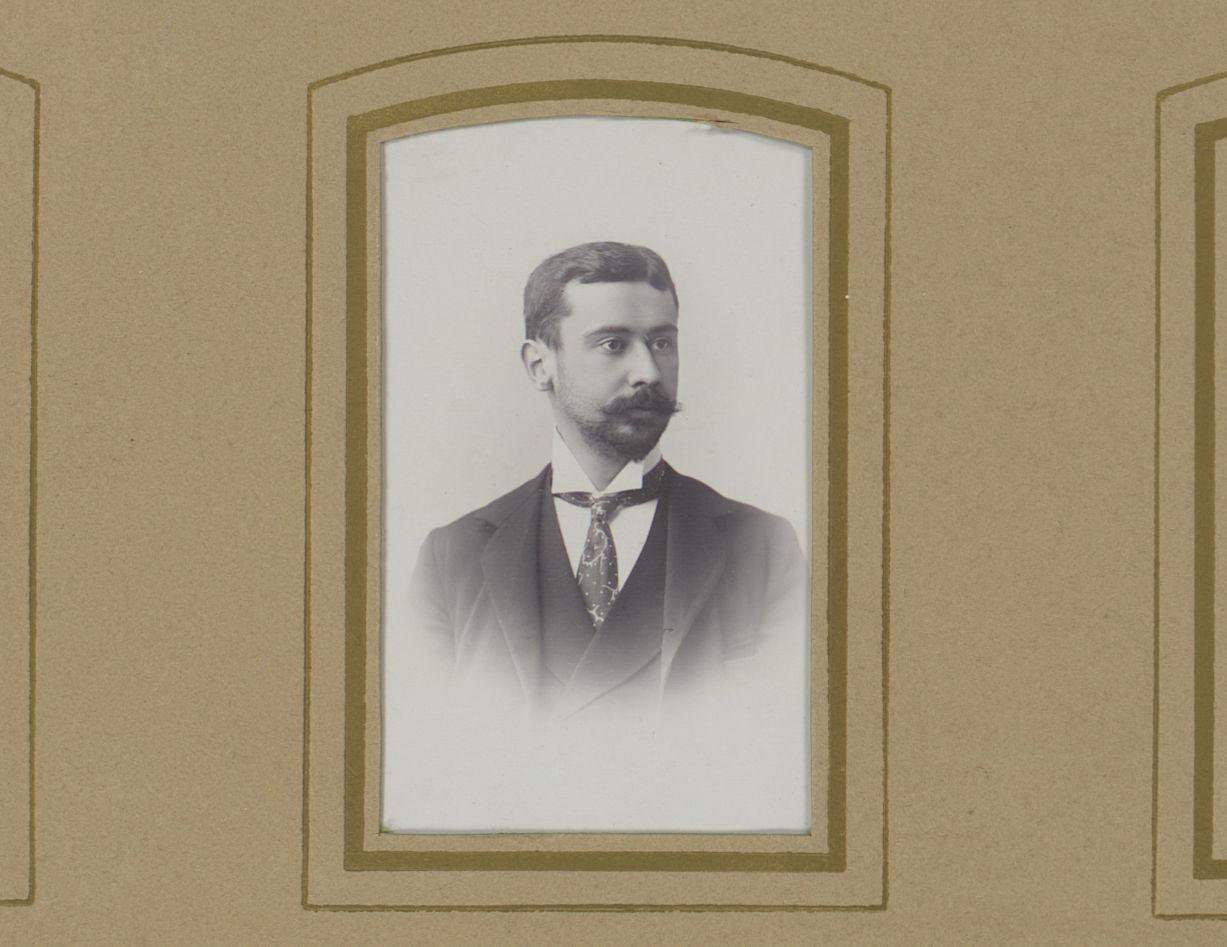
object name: album leaf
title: Portret van een man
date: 1894-1907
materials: cardboard, photographic support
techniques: matte daylight collodion silver print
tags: historical persons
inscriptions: inscription: ‘Koene & Büttinghausen/ Amsterdam/ Heerengracht 150./ Batavia.’